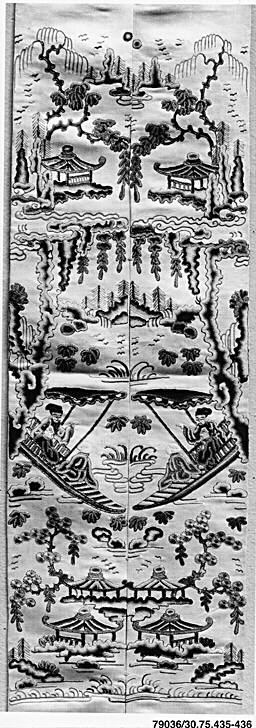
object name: sleeve band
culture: chinese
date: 1801-1900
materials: metal thread, silk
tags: houses,boats